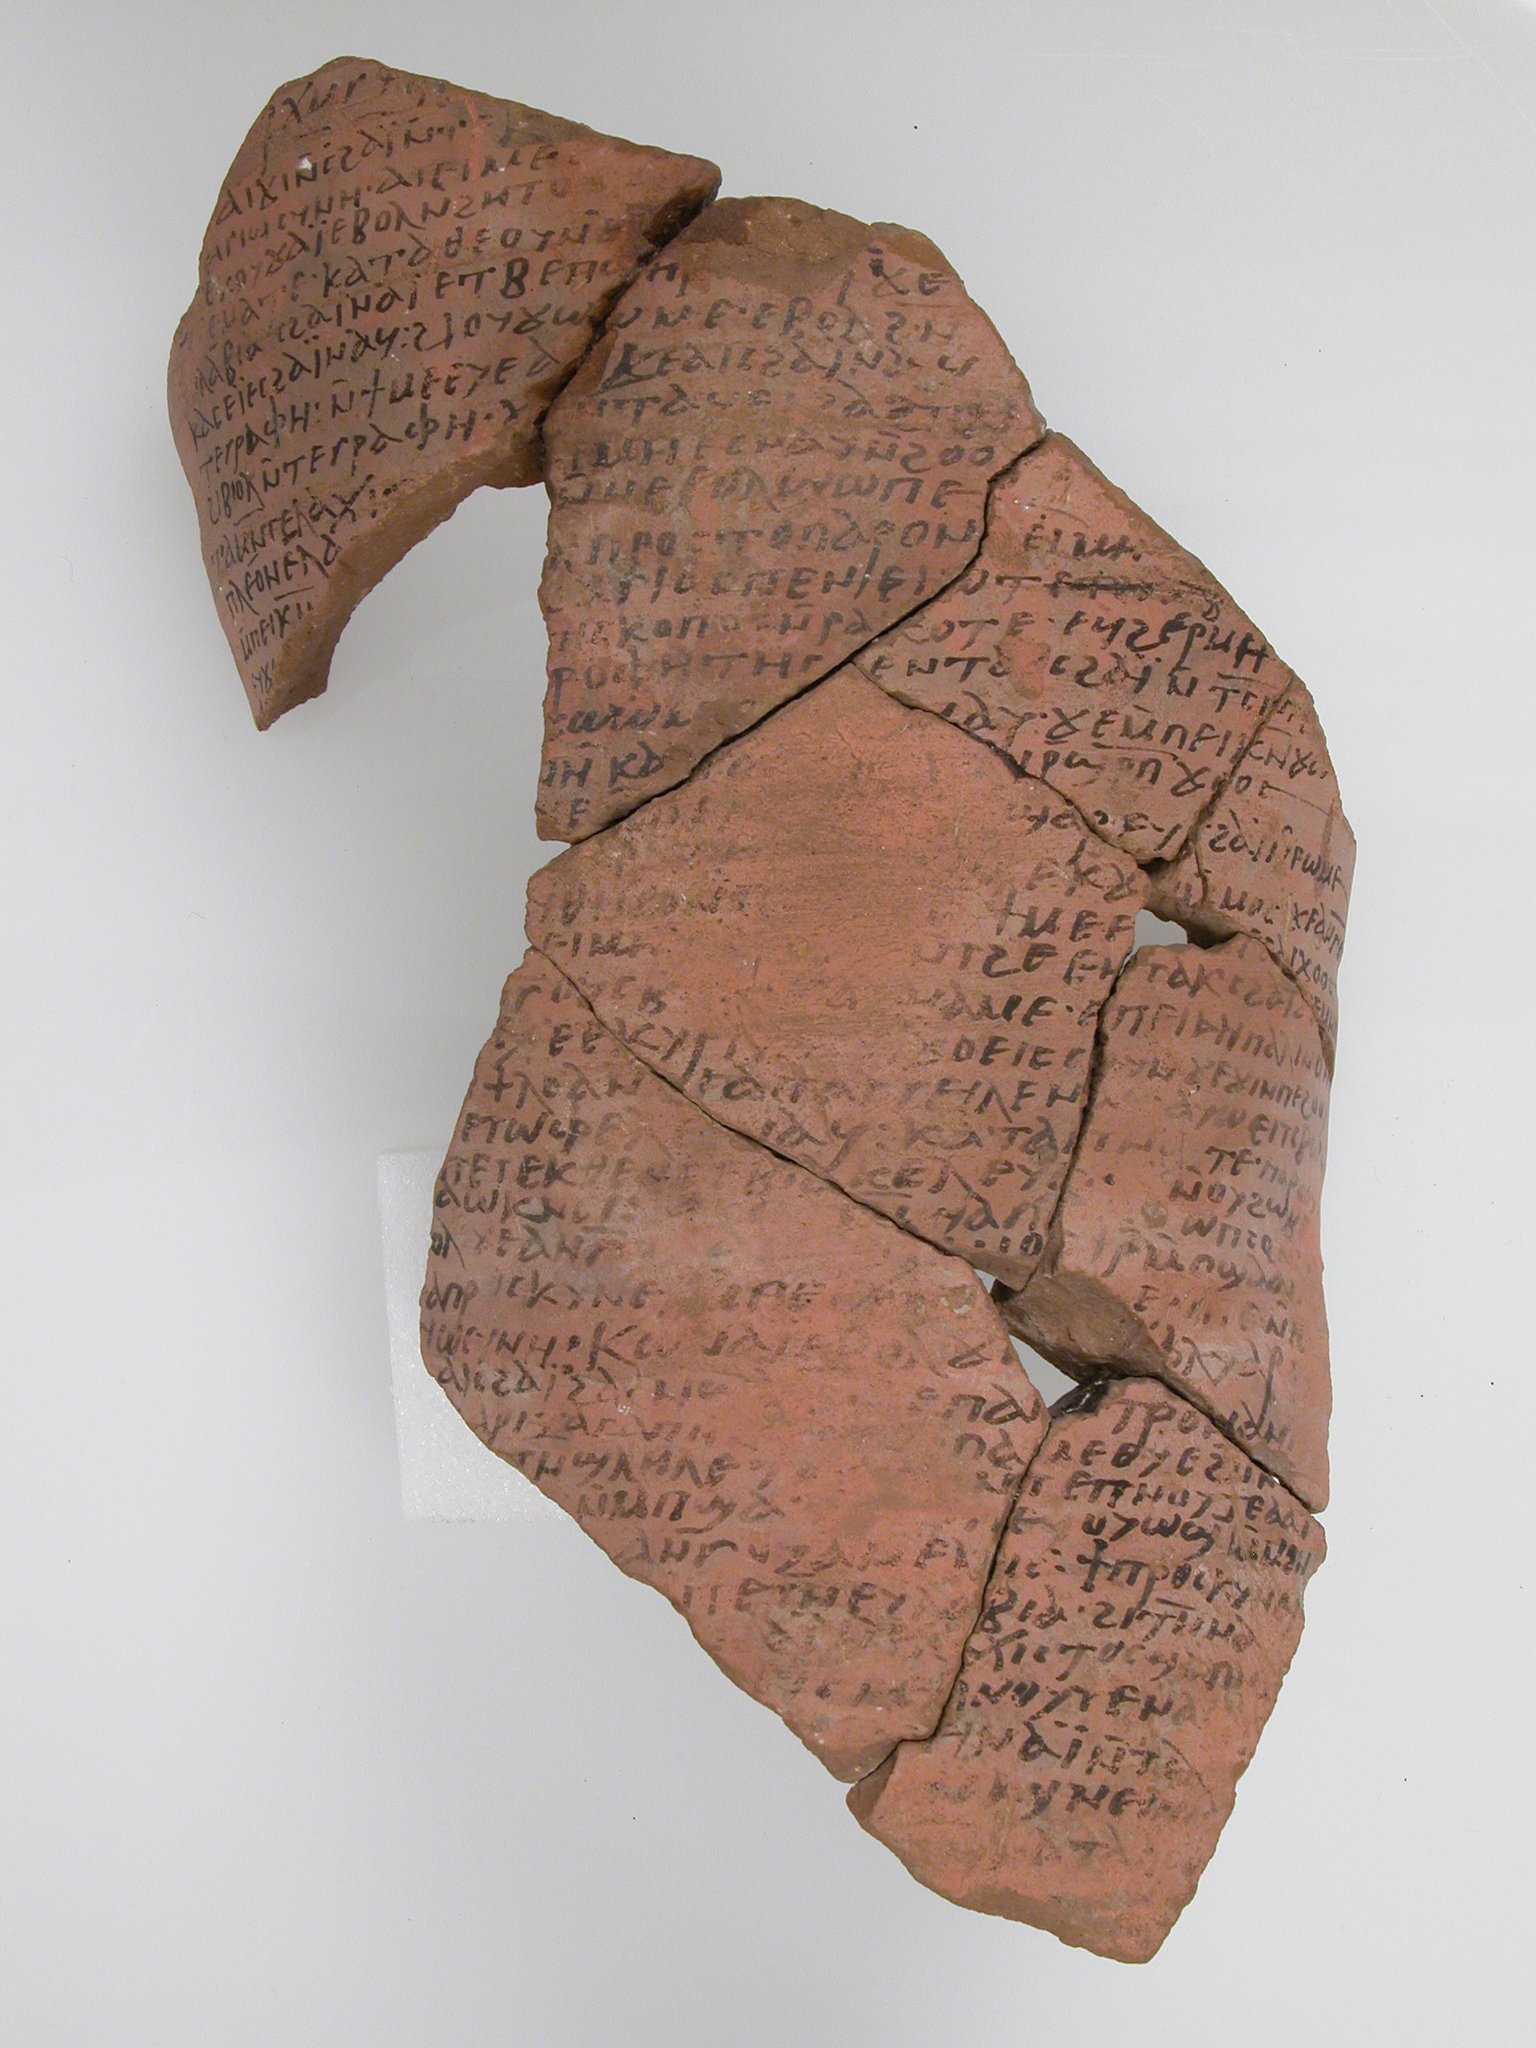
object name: ostrakon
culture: coptic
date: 601-700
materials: ink, pottery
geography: egypt